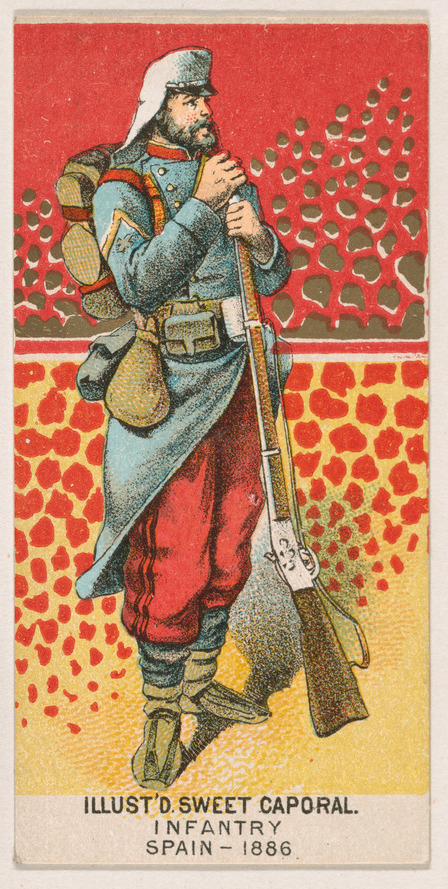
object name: print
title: Infantry, Spain, 1886, from the Military Series (N224) issued by Kinney Tobacco Company to promote Sweet Caporal Cigarettes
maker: kinney brothers tobacco company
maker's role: publisher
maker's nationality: american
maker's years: 1869-2011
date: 1888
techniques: color lithograph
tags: military,firearms,men,profiles